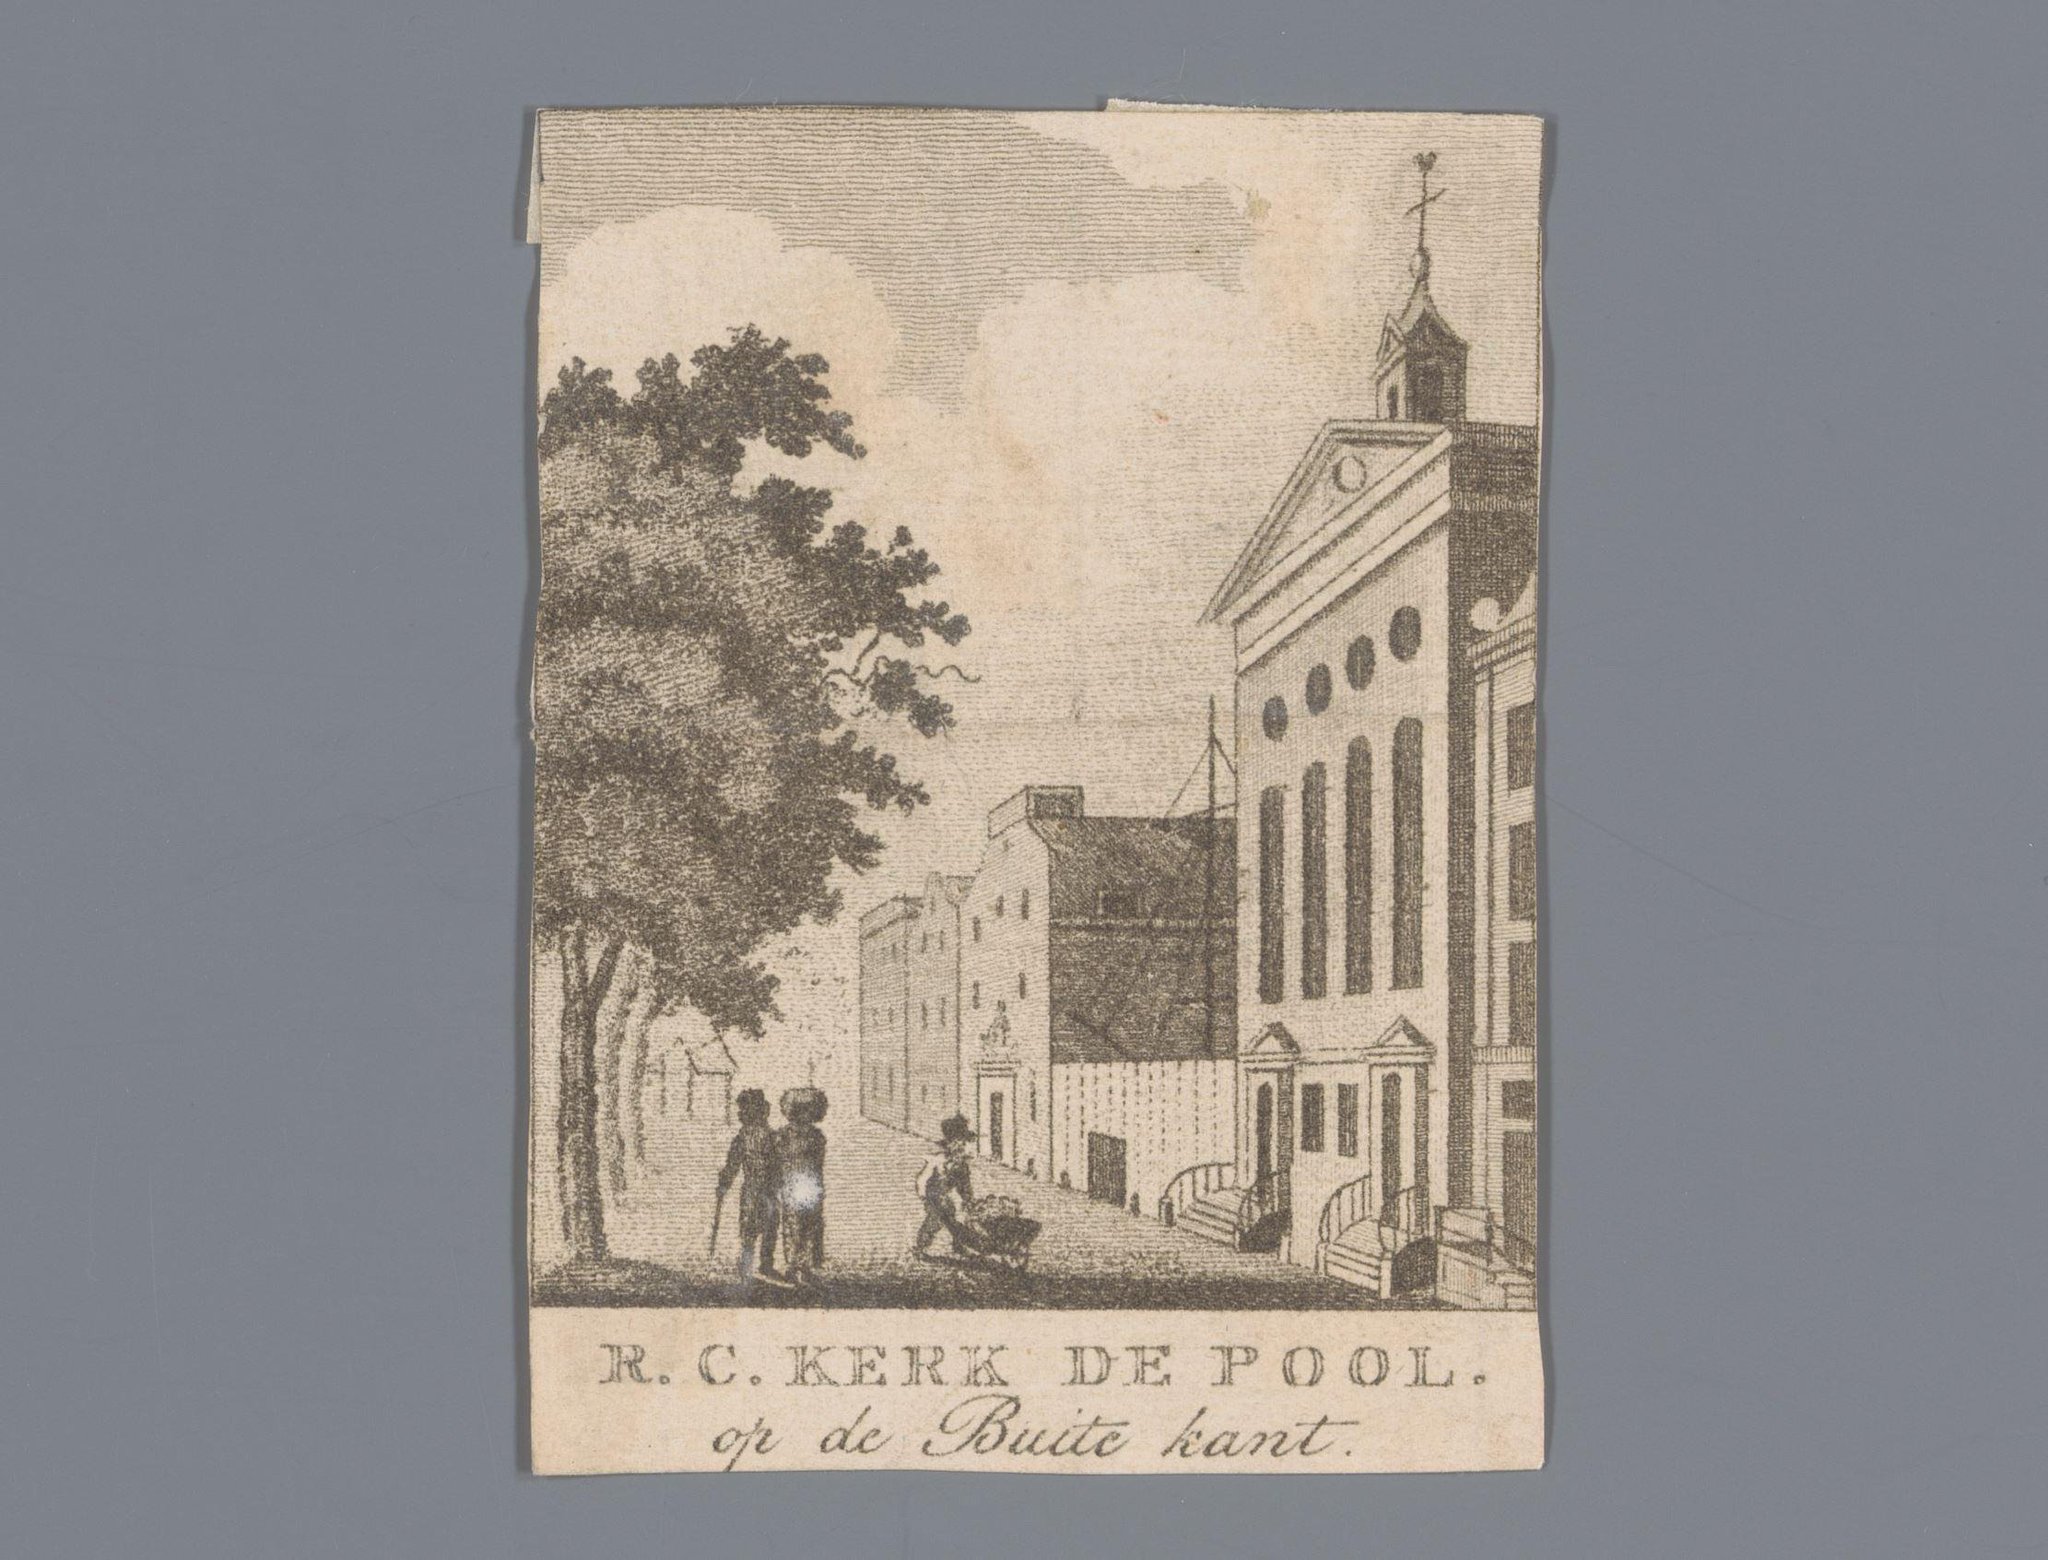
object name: print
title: Gezicht op de Rooms Katholieke kerk De Pool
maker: Anonymous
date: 1826-1830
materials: paper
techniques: etching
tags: roman catholic church, amsterdam